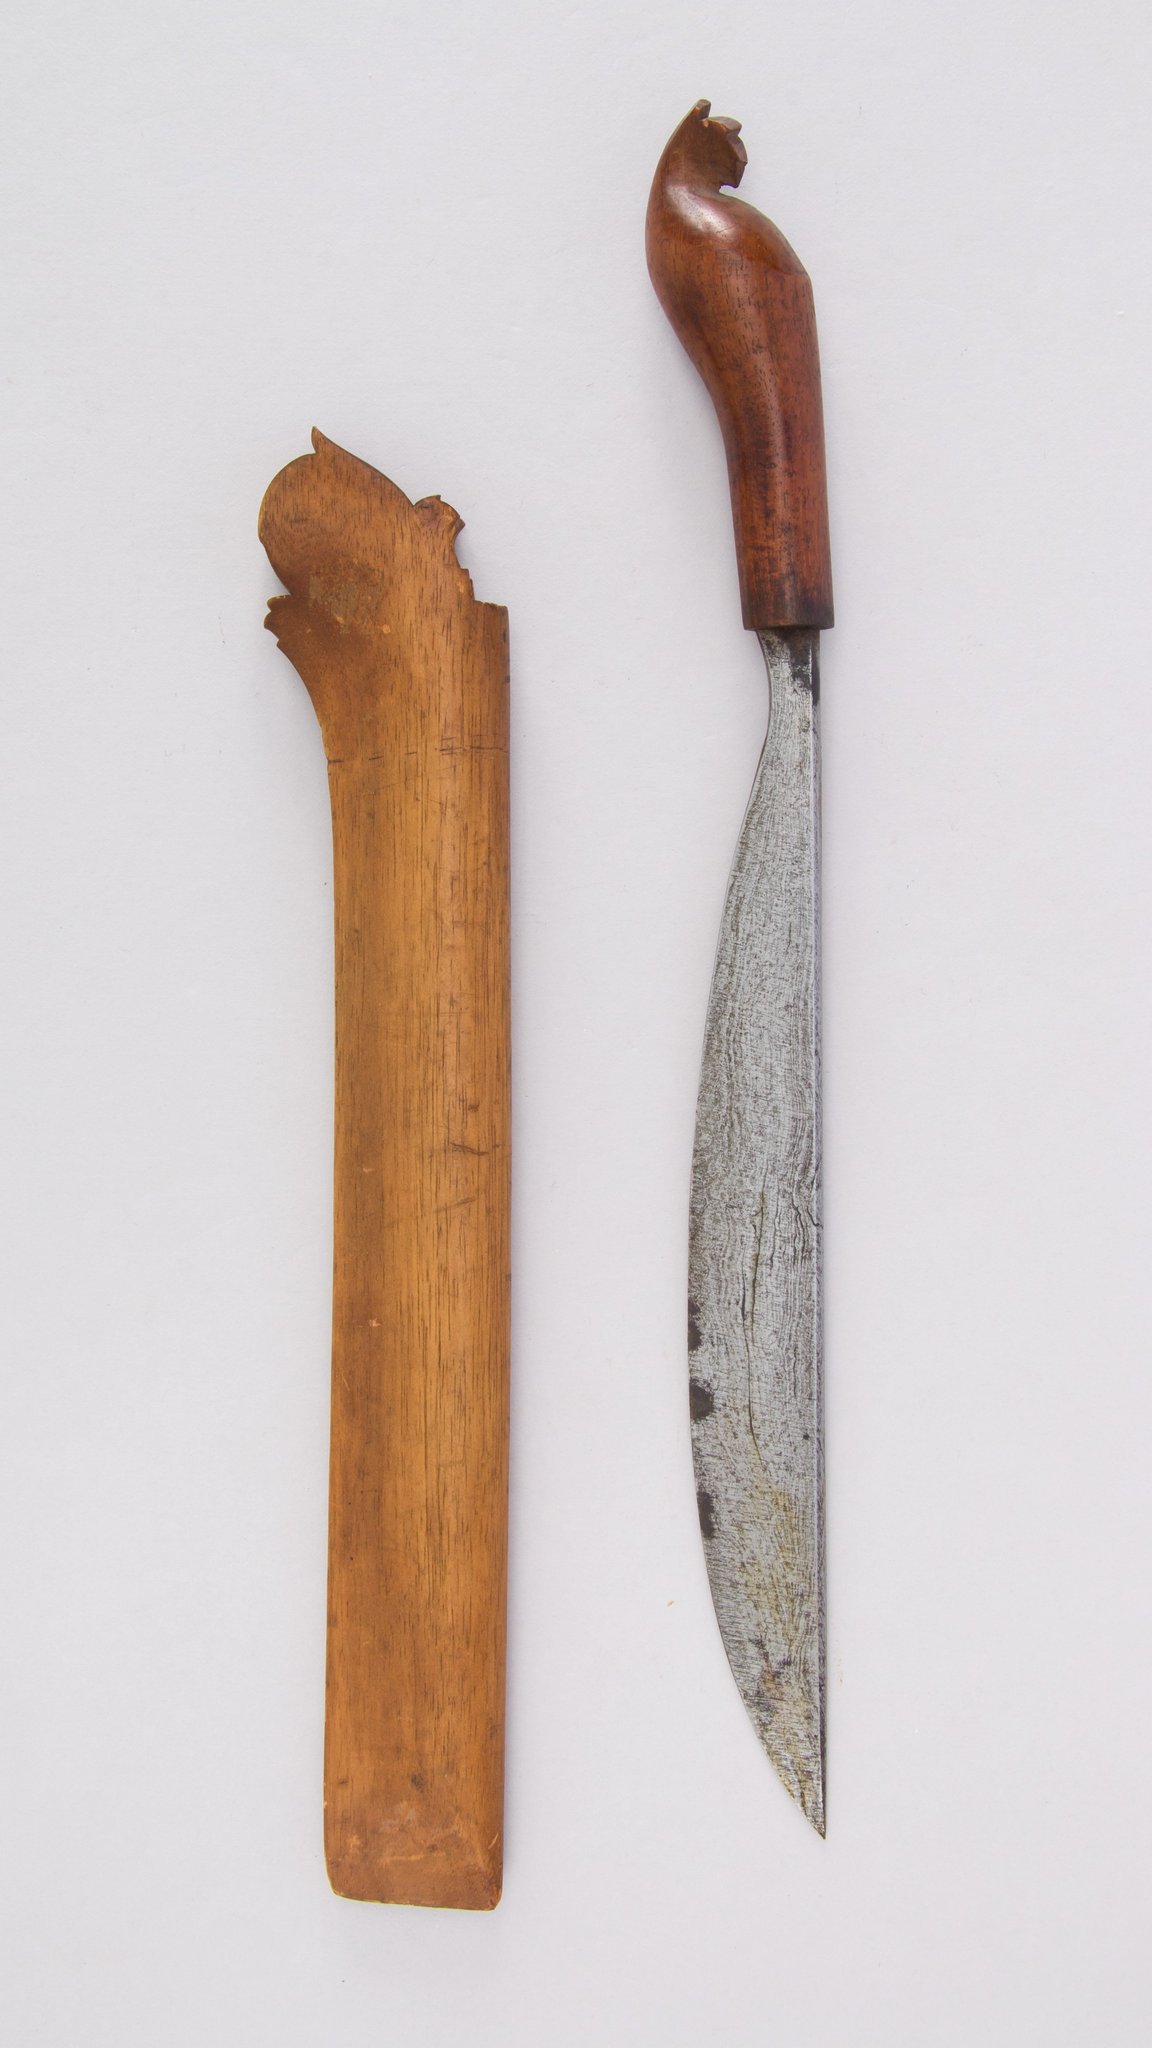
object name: knife golok with sheath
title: Knife (Golok) with Sheath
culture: malayan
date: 1701-1900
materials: wood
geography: malaysia